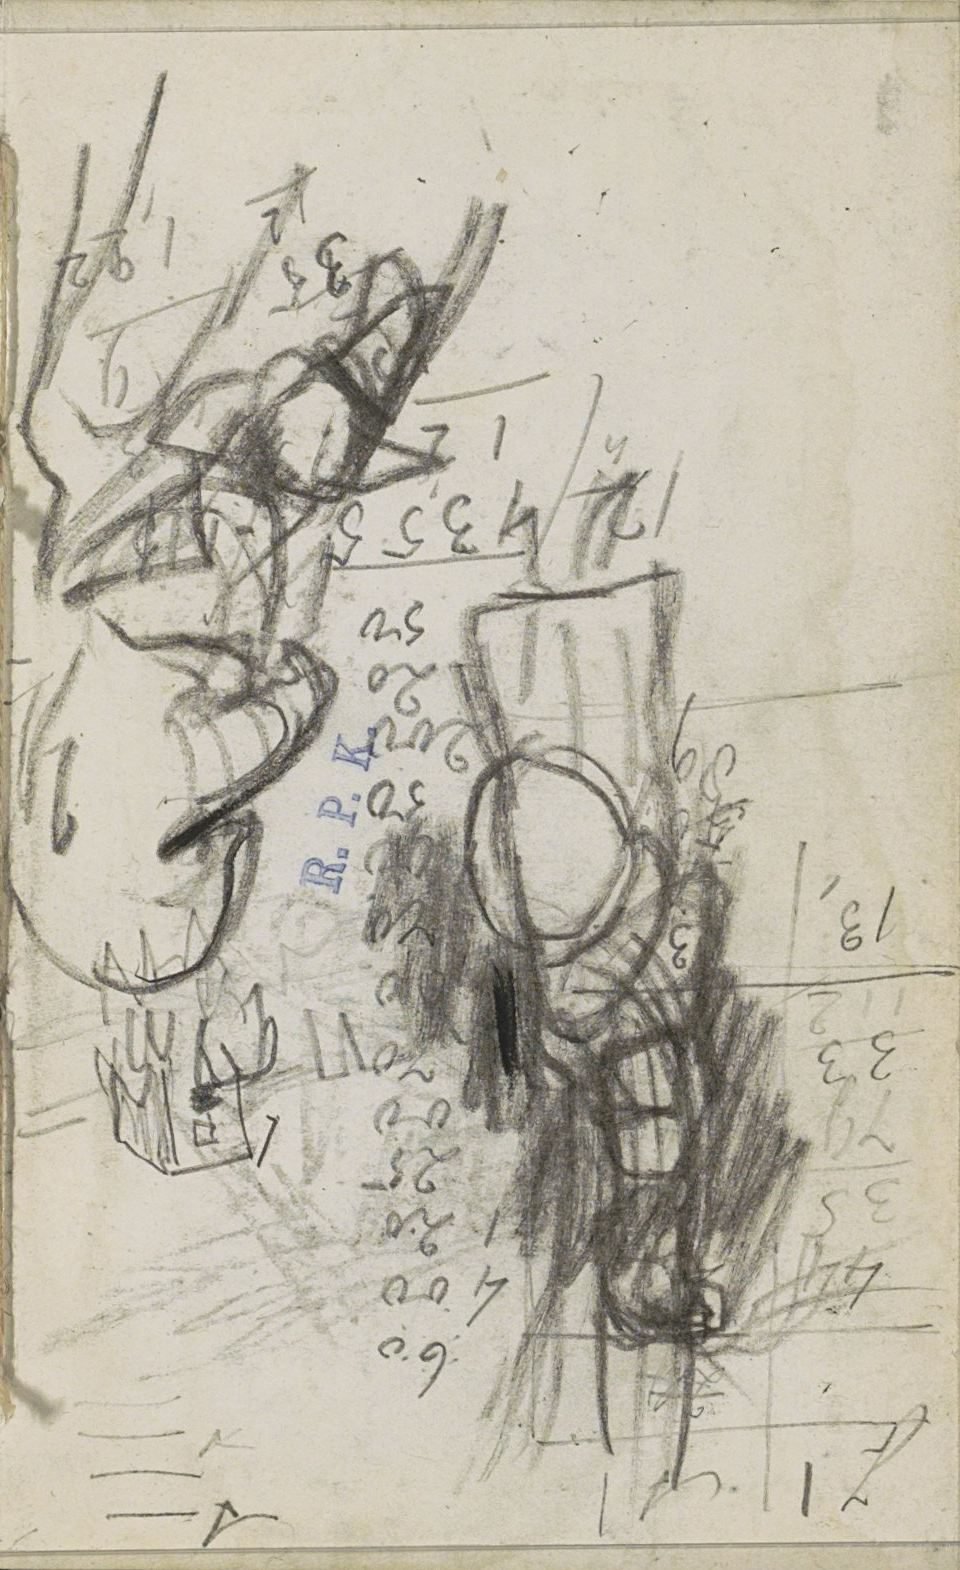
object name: sketchbook leaf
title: Studies, mogelijk figuren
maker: anton mauve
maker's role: draughtsman, painter, print maker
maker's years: 1838-1888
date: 1848-1888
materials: chalk, paper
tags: anatomy (non-medical)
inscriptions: collector's mark: Lugt L.2233, annotation: ‘[...]’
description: Blad 1 recto uit een schetsboek met 53 bladen.